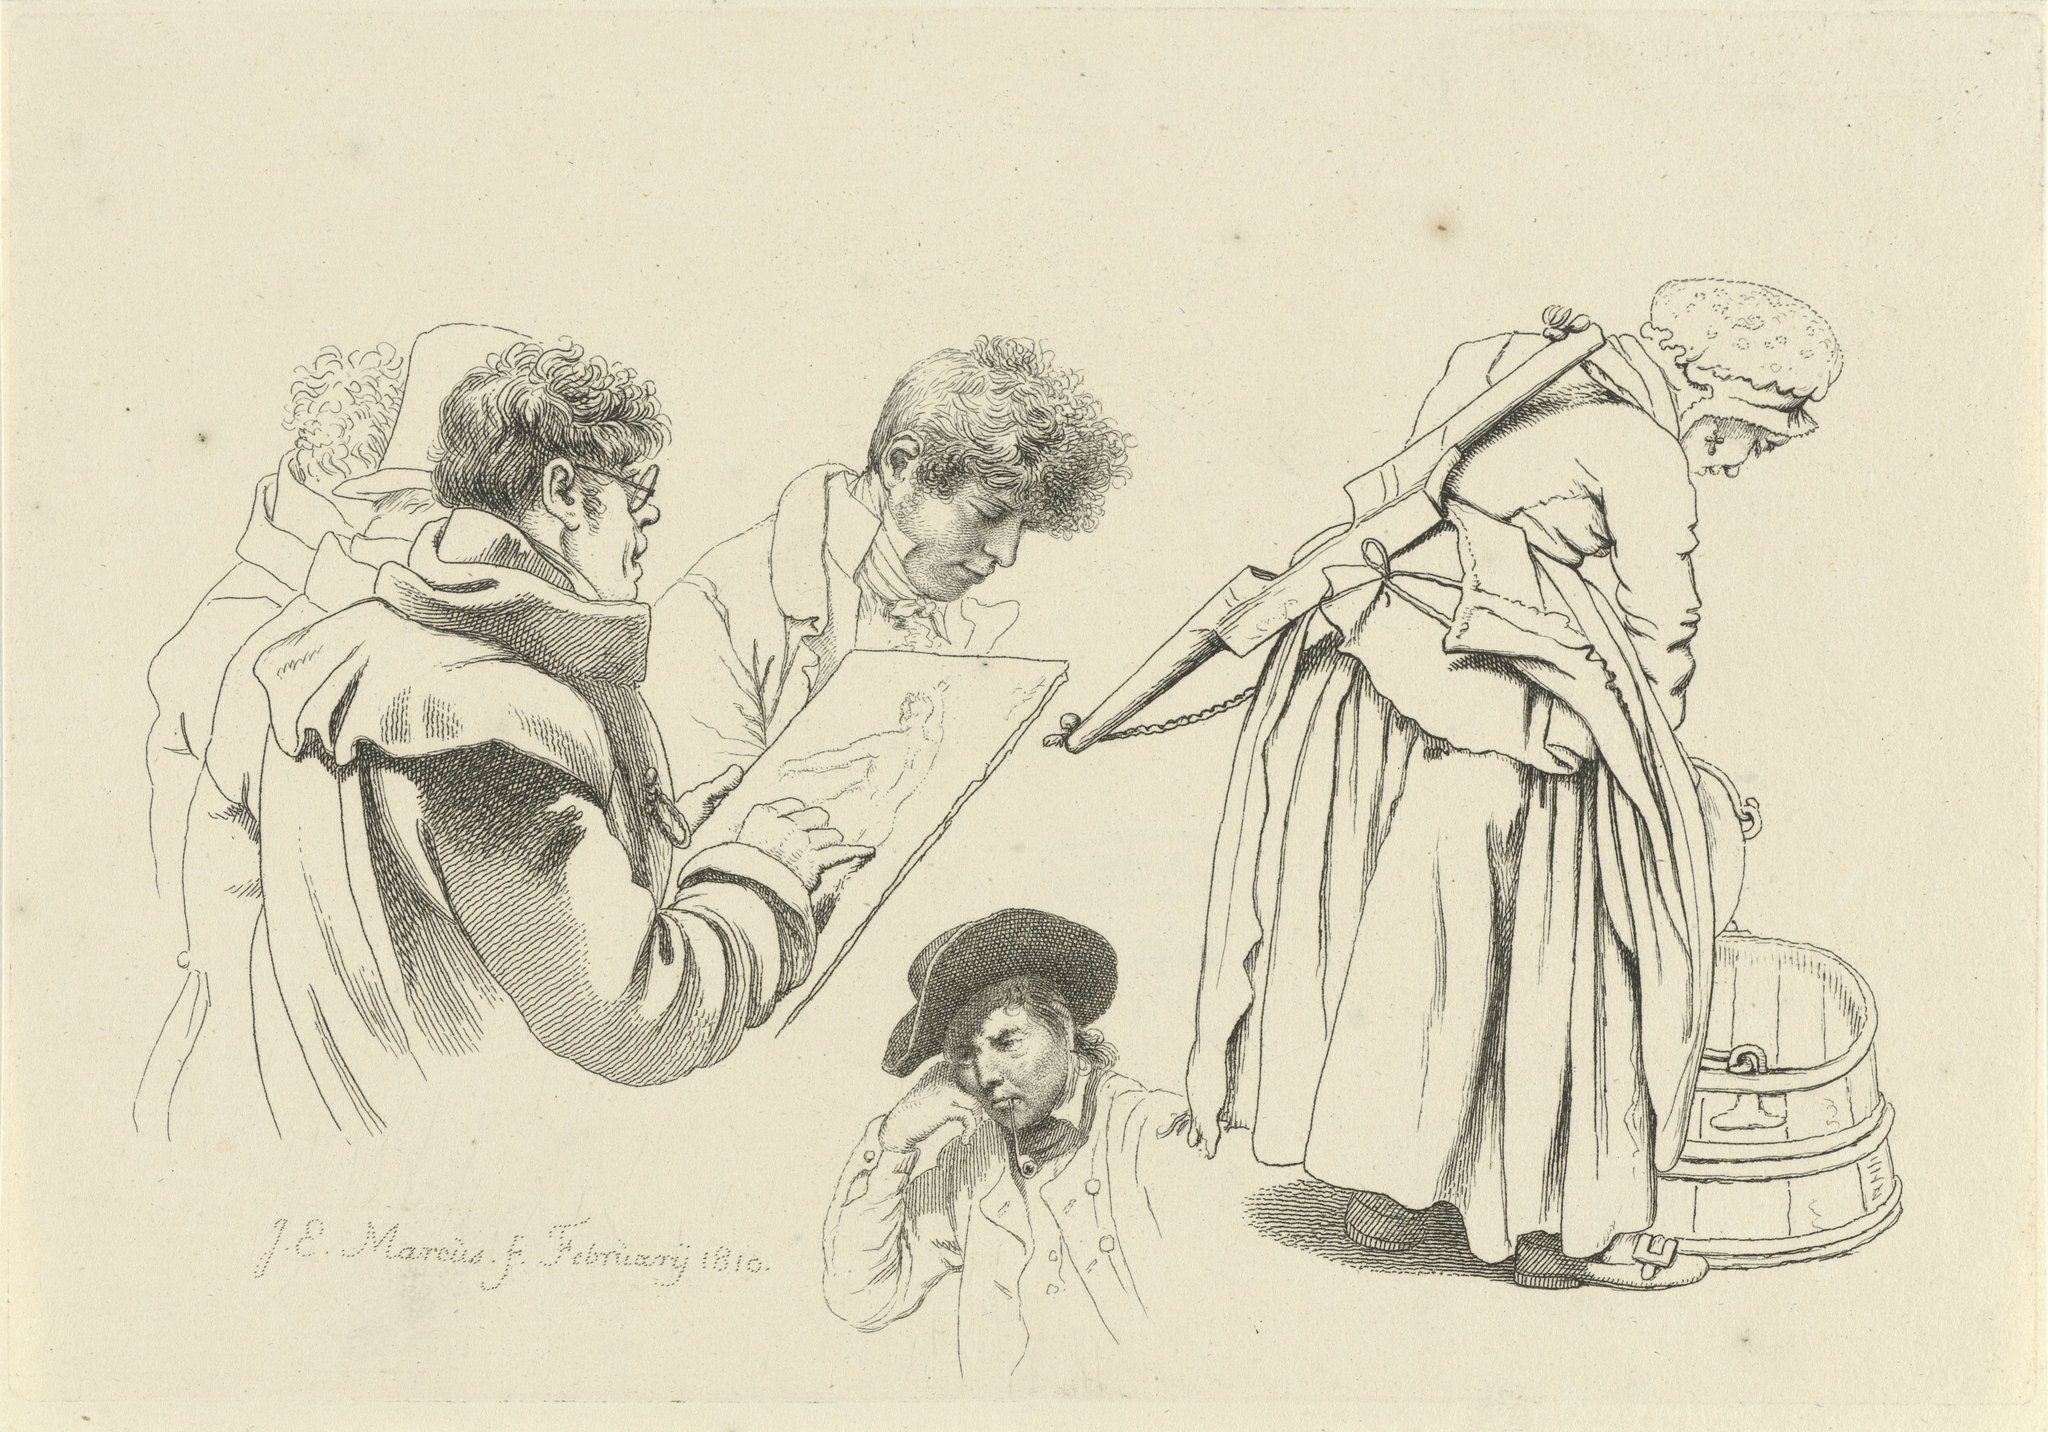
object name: print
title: Verschillende figuren, waaronder portretten van Harmanus Langerveld en Anthonie Joseph Helant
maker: jacob ernst marcus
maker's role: draughtsman, print maker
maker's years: 1774-1826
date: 1802-1810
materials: paper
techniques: etching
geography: amsterdam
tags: lille, the hague, painter, anthonie joseph helant, amsterdam, print maker, harmanus langerveld, artist (in general) (+ making preliminary designs, sketching), milkmaid, yoke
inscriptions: collector's mark: Lugt 2228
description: Studieblad met tekenaars, waaronder de portretten van de kunstenaars Harmanus Langerveld en Antonie Joseph Helant, een melkvrouw met een juk op haar rug bij een tobbe en een buste van een man met zijn hoofd rustende op zijn hand.